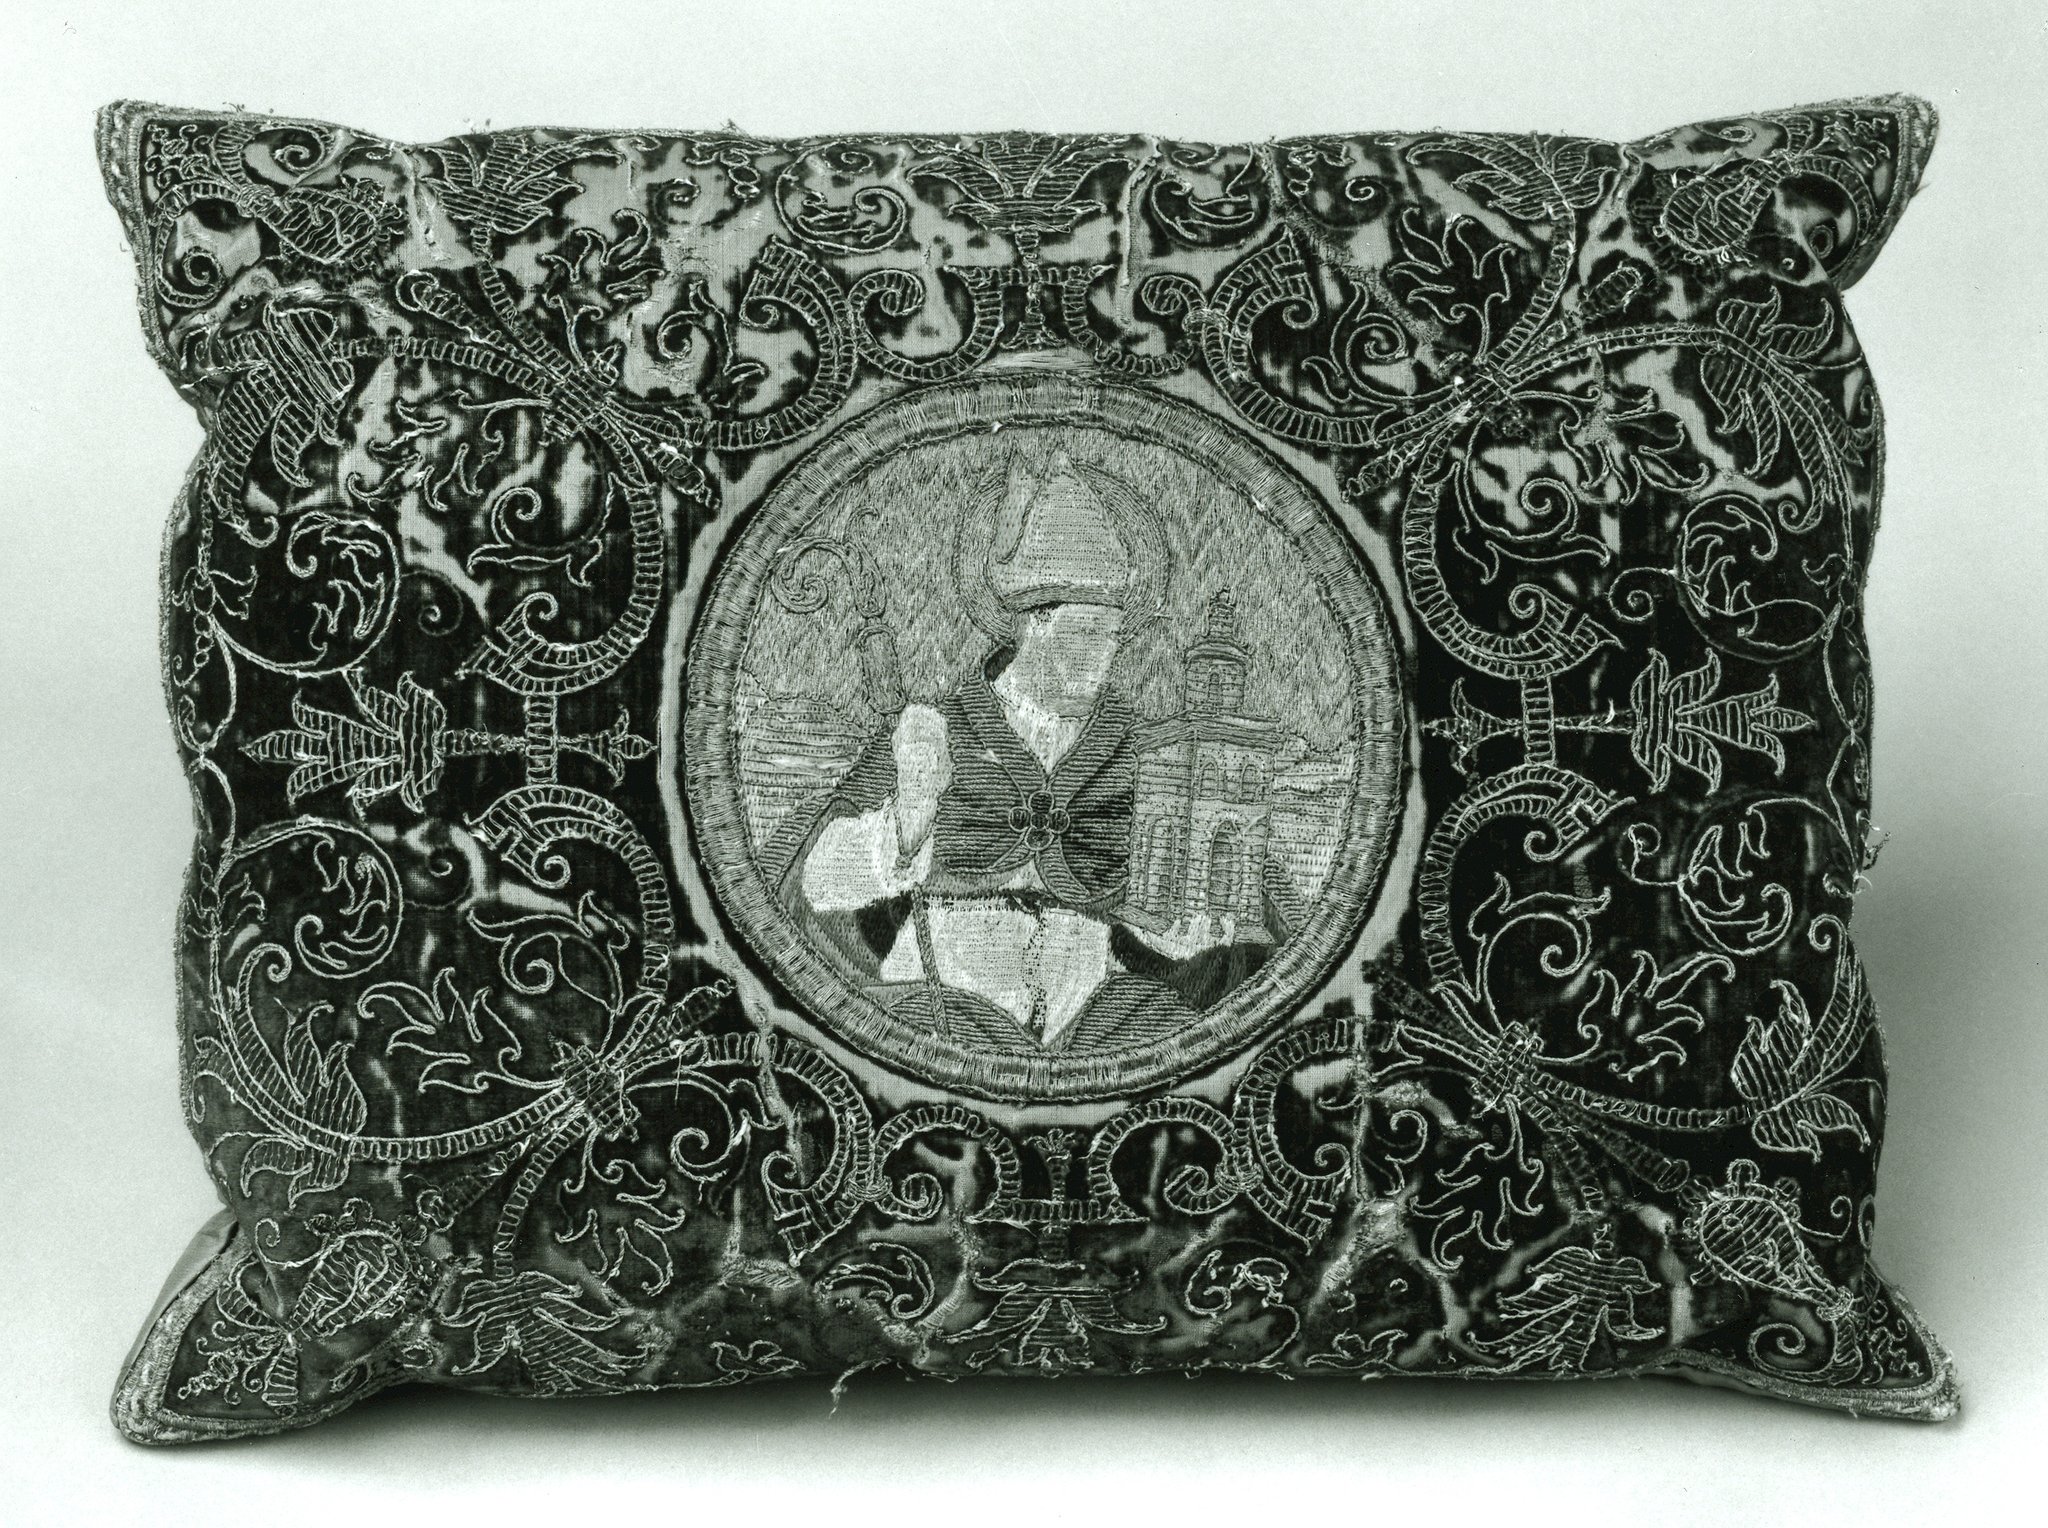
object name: roundel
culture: italian or spanish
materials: gilt, linen, metal, metal thread, silk, velvet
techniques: embroidery, cutting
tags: men